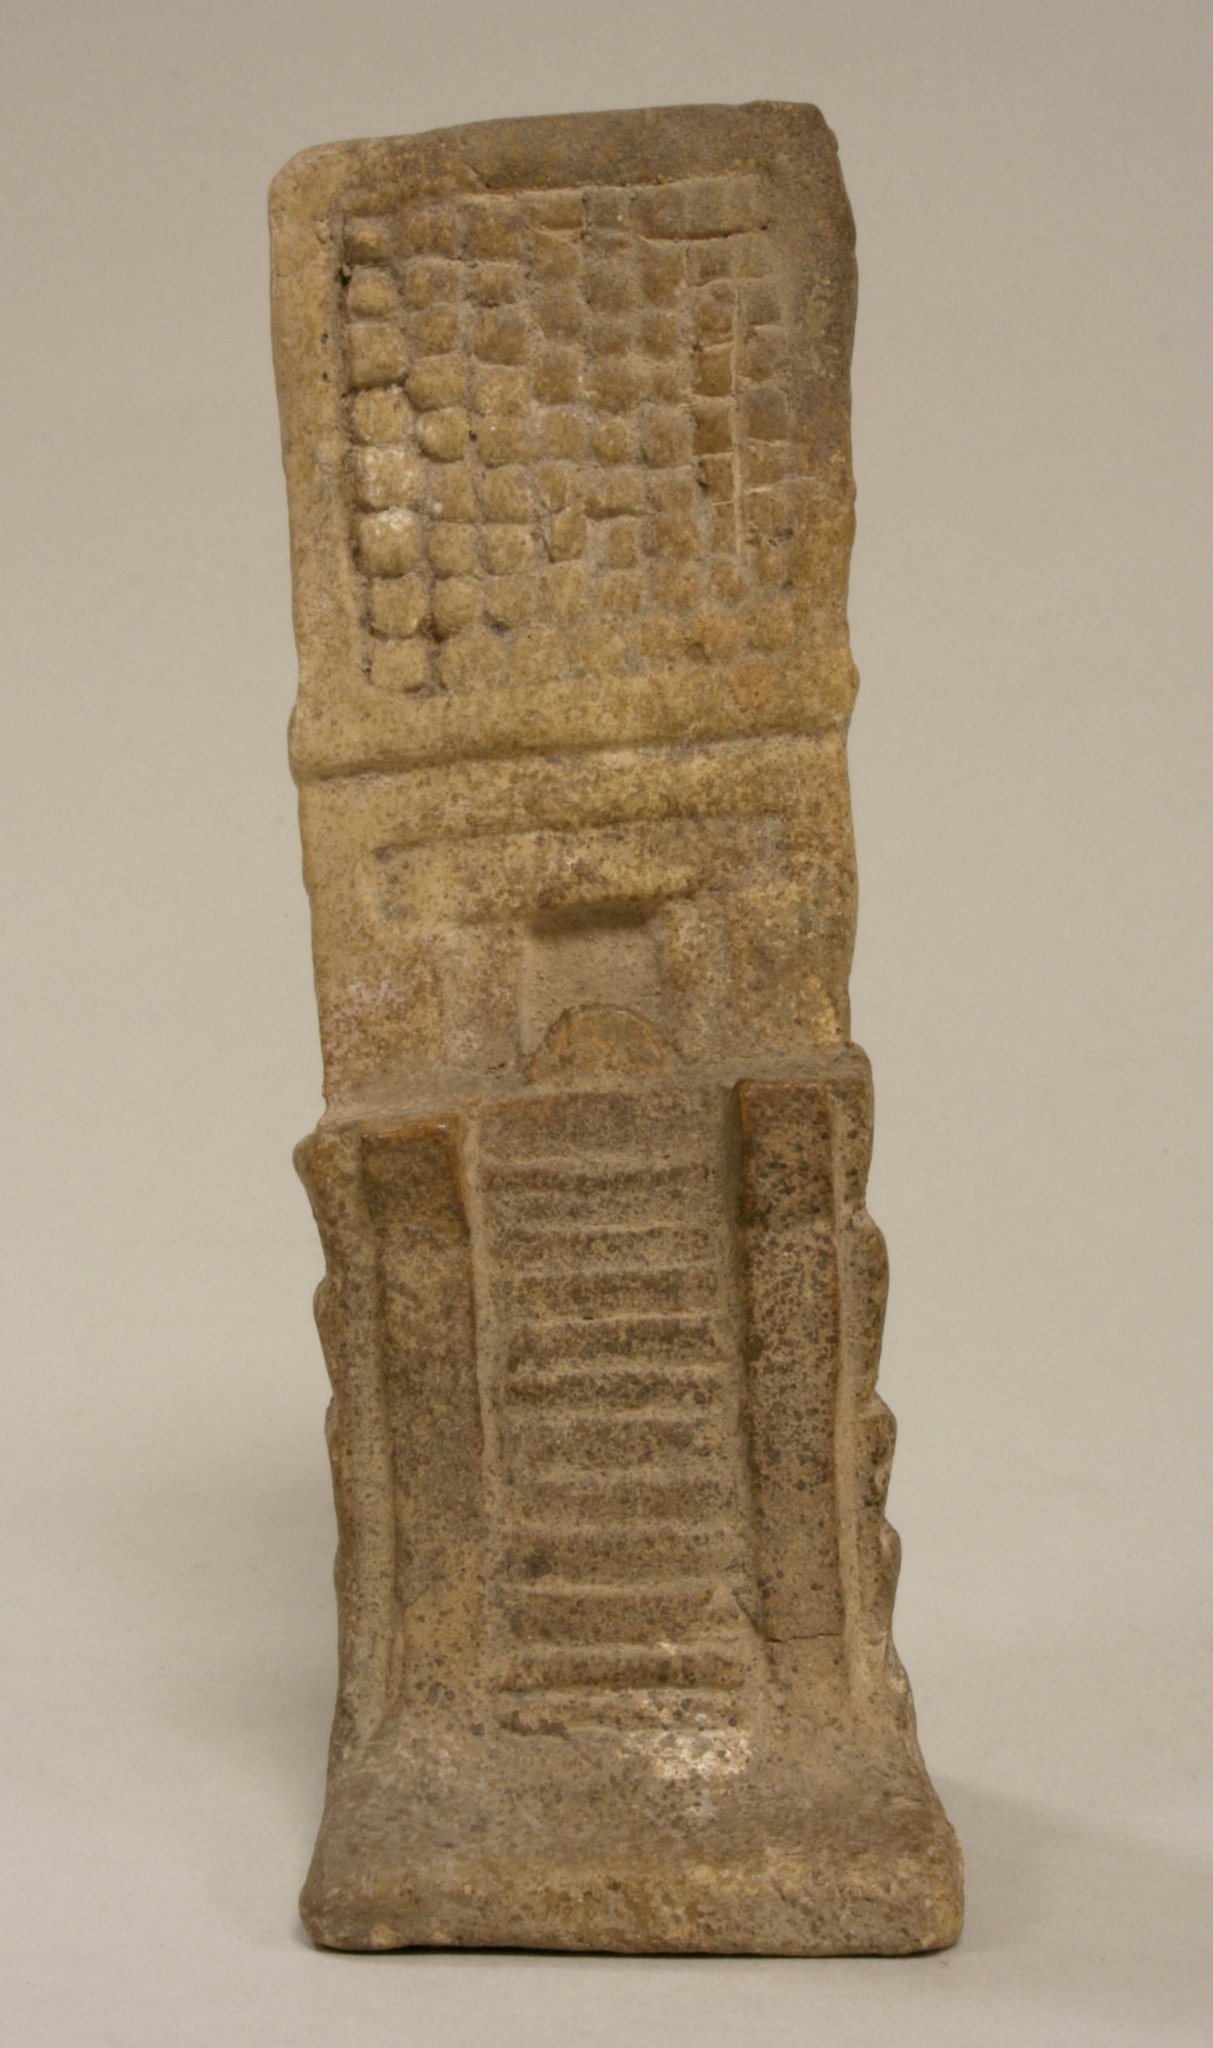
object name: temple model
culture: mexica, aztec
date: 1401-1533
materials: ceramic, pigment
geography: mexico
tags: temples